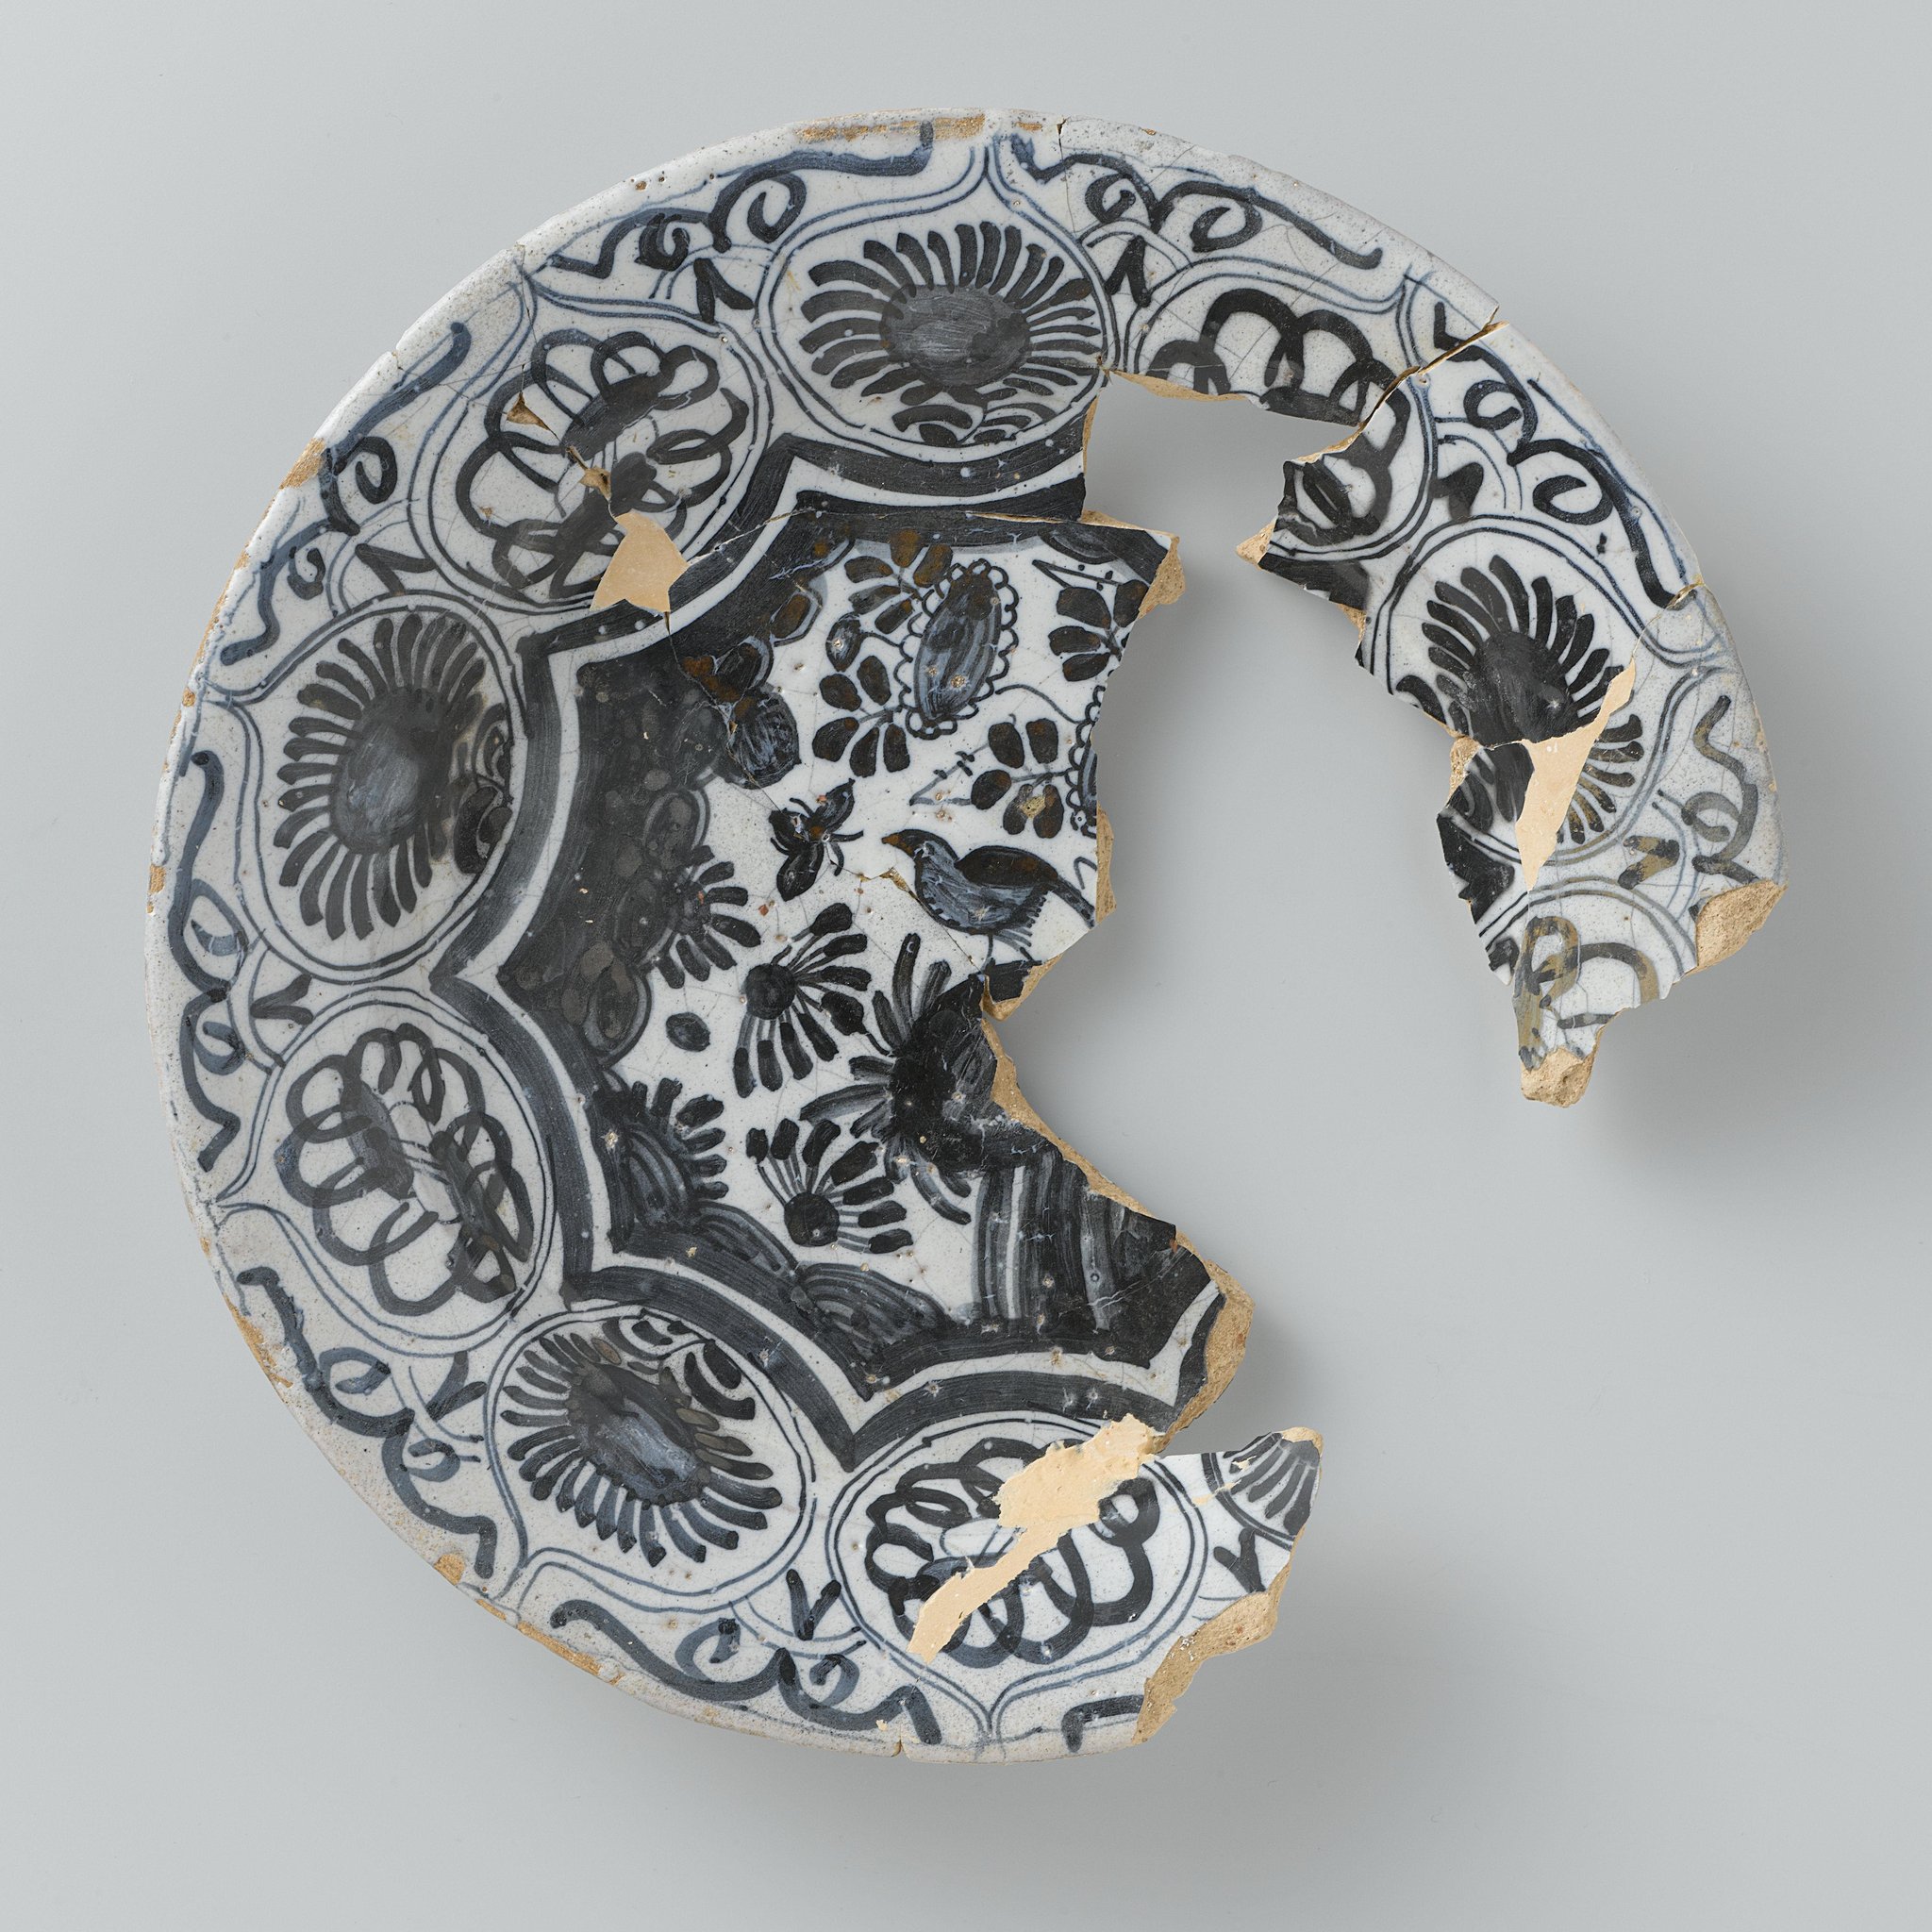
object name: plate dish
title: Bord, fragment, met op het plat een vogel in blauw. Rand met Wan Li decor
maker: Anonymous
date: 1650-1690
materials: earthenware, glaze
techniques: painted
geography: delft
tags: delft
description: Rond bord (fragmentarisch) van blauw beschilderde faience, met een Wan-Li rand en een vogel op het plat. Het bord is een bodemvondst uit Delft.